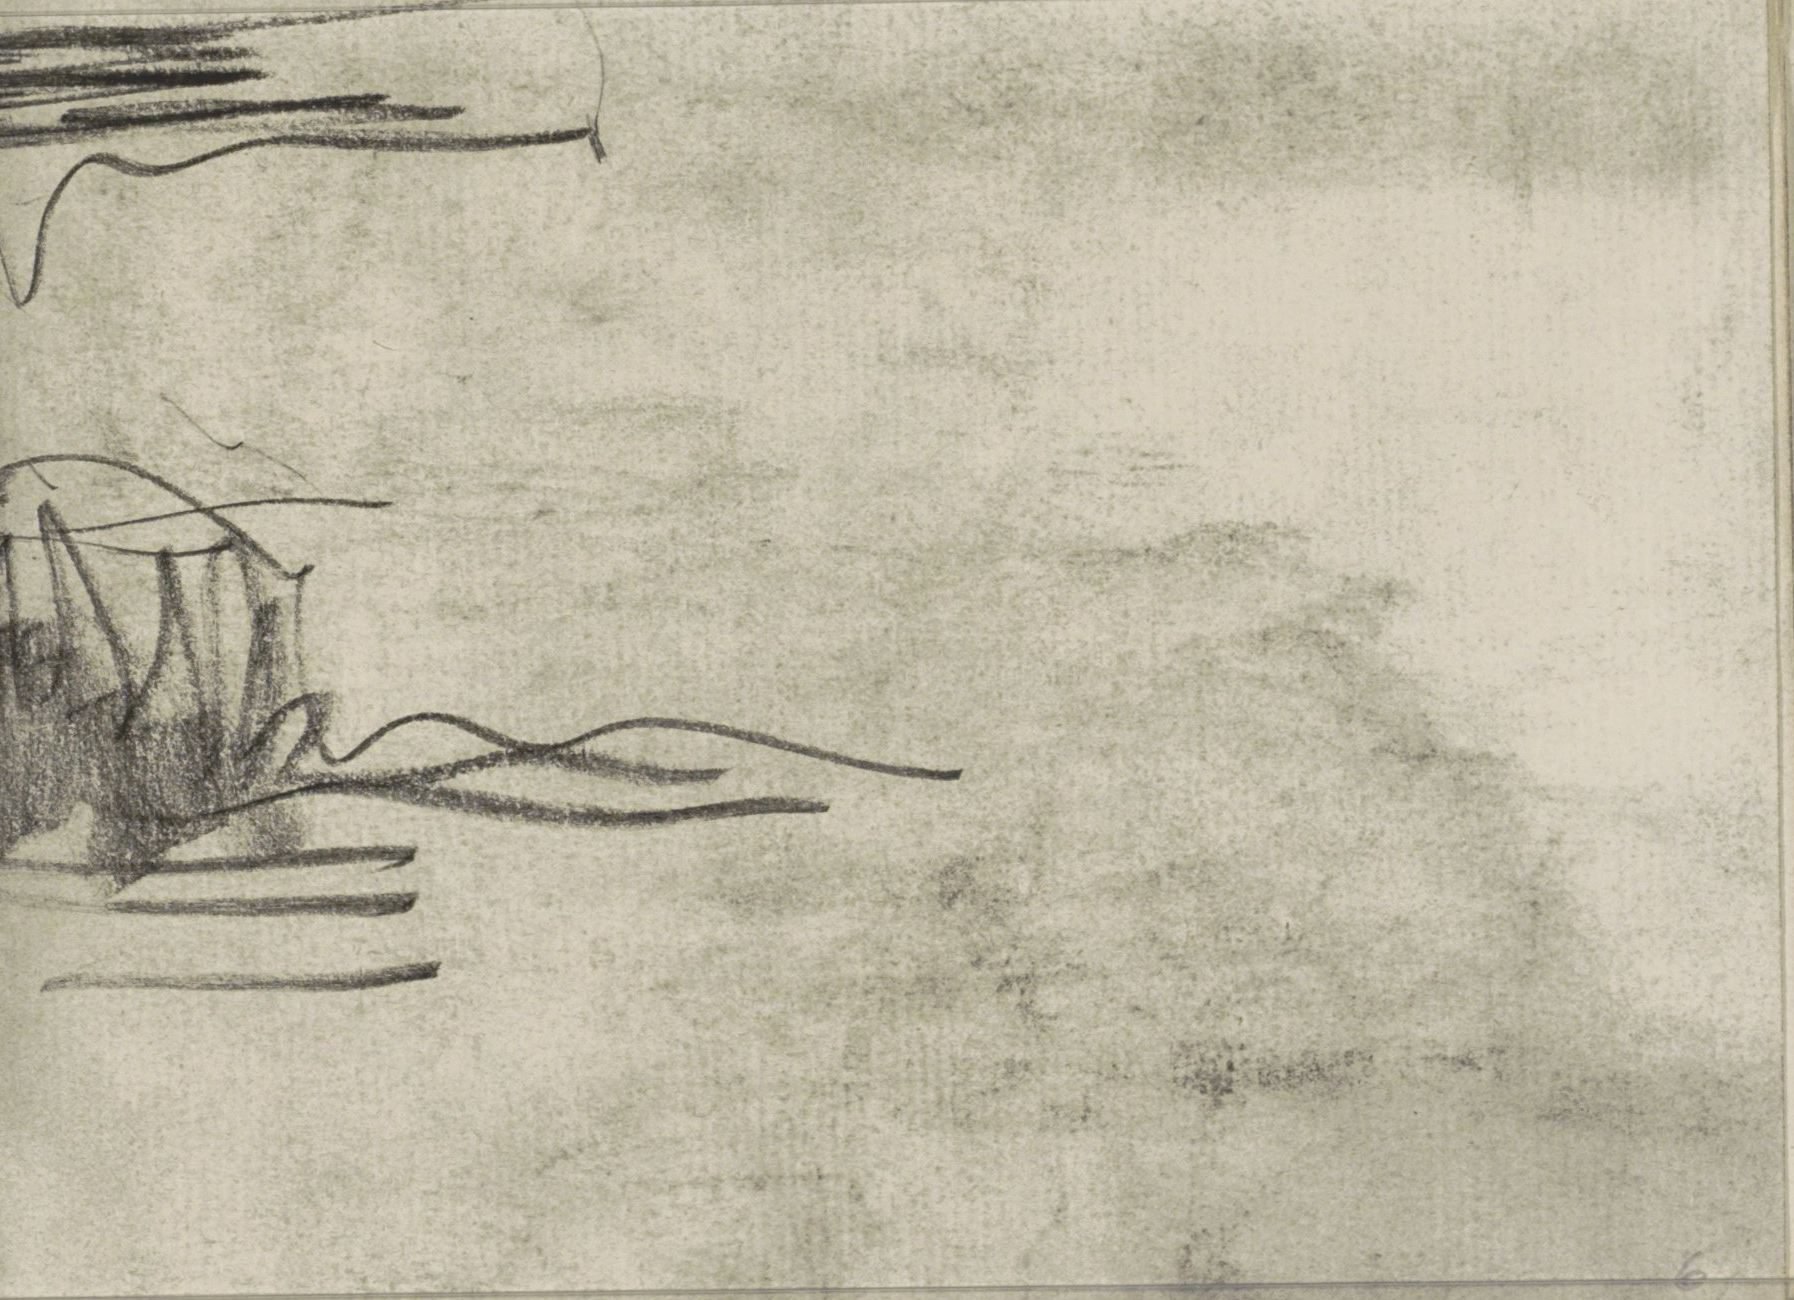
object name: sketchbook leaf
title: Studie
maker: isaac israels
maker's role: draughtsman, painter, print maker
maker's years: 1865-1934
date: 1875-1934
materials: chalk, paper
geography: amsterdam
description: Blad 6 recto uit schetsboek XXXI met 10 bladen.